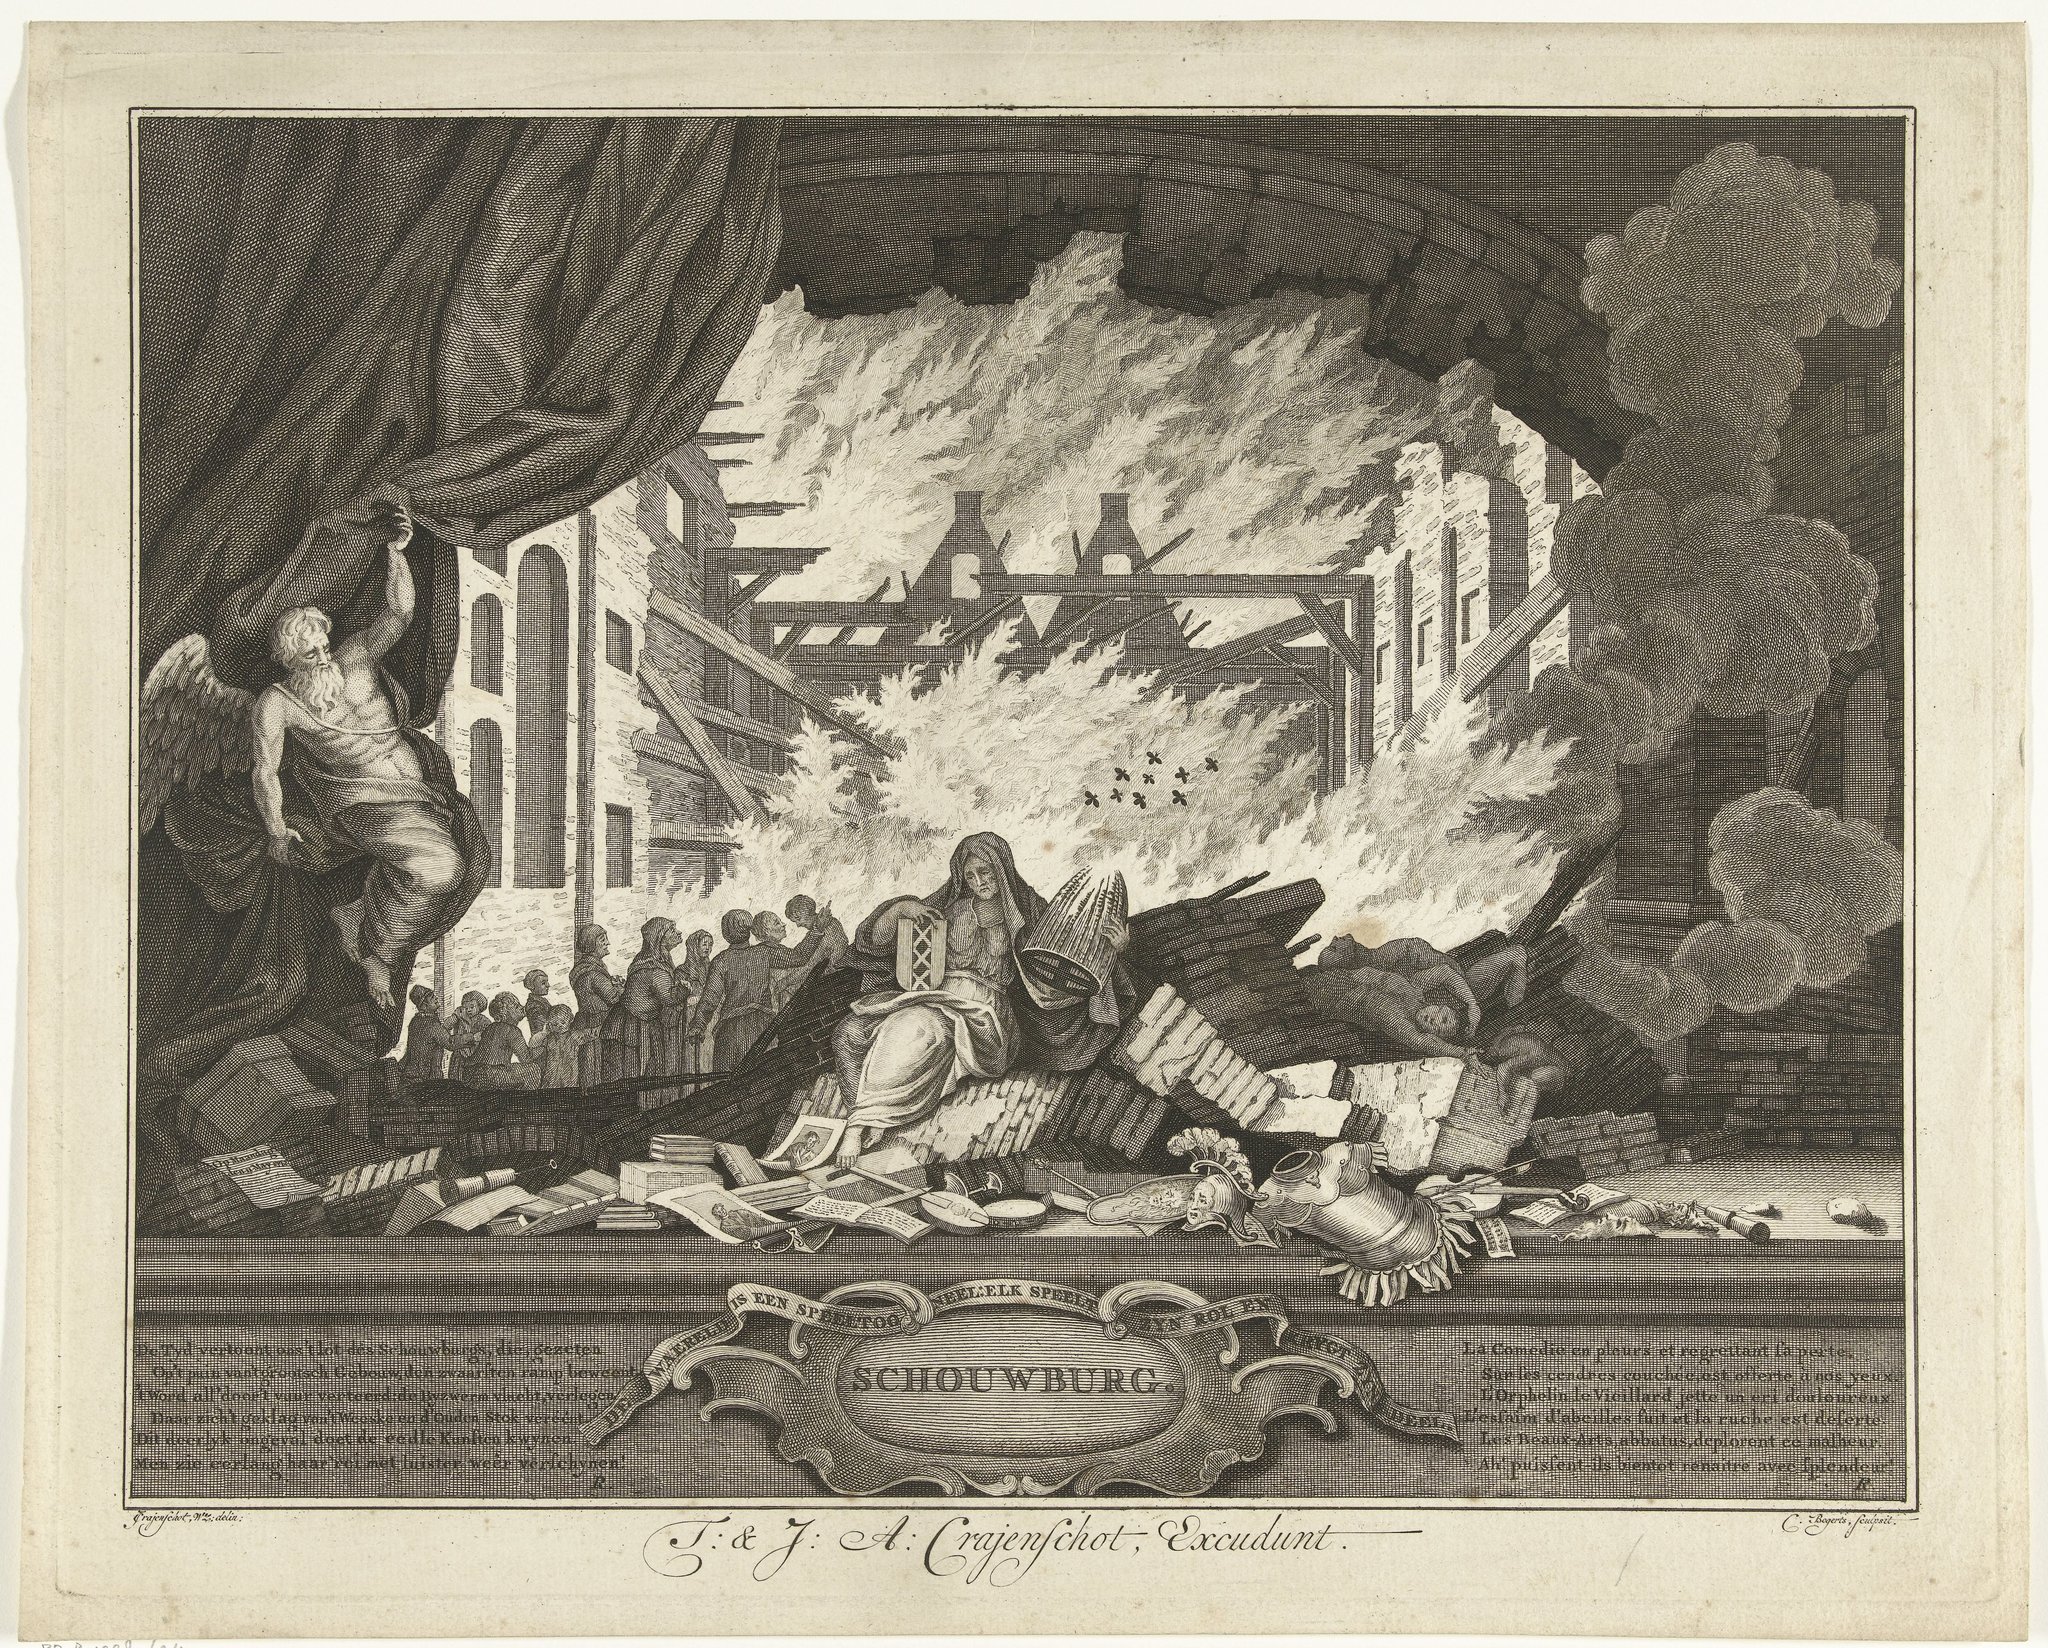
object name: print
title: Schouwburg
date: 1772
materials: paper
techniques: engraving, etching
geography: amsterdam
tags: on fire, ablaze, theatre, theatrical performance, theatre (building), father time, man with wings and scythe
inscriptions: collector's mark: Lugt 2228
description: Titelprent voor de serie van vier prenten over de brand in de Amsterdamse Schouwburg aan de Keizersgracht op 11 mei 1772. Vader Tijd trekt het gordijn van het ruïneuze toneel opzij om de brandende schouwburg te onthullen. Te midden van de ruïnes zit de bedroefde personificatie van de Amsterdamse Schouwburg met het wapen van de stad en een verbrande bijenkorf, waaruit de bijen zijn ontsnapt, in haar handen. Onder het toneel een cartouche met de titel en het bekende vers van Vondel ('De waereld is een speeltooneel: elk speelt zyn rol en krygt zyn deel'). Links en rechts daarvan een zesregelig vers in het Nederlands (links) en Frans (rechts).